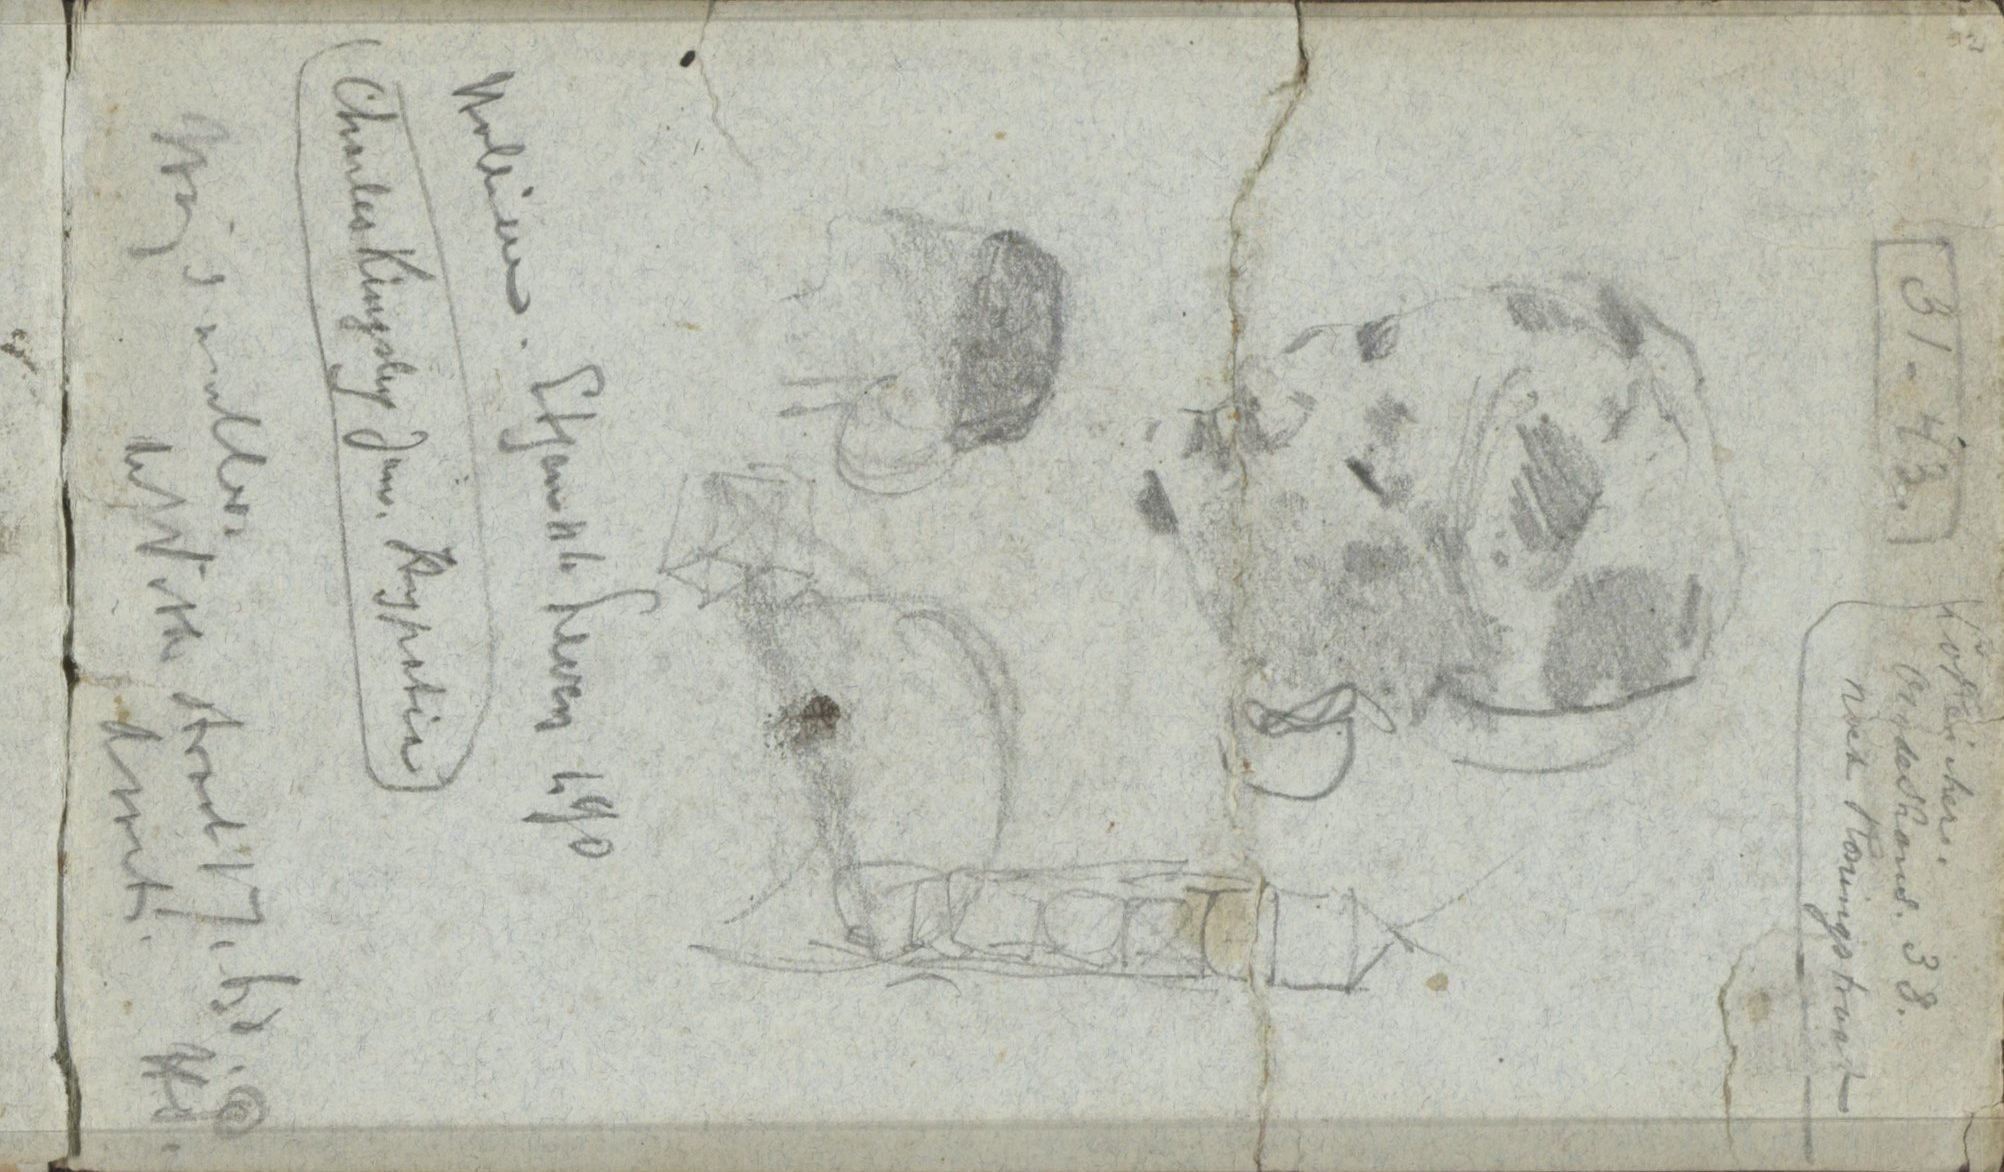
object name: endleaf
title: Hoofden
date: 1881-1883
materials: paper, pencil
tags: head (human), head (human) - aa - female human figure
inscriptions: annotation: ‘31-43/ [...]/ Charles Kingsley Jan[?] Hypatia/ [...]’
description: Pagina 62, achterste schutblad, uit een schetsboek met 30 bladen.